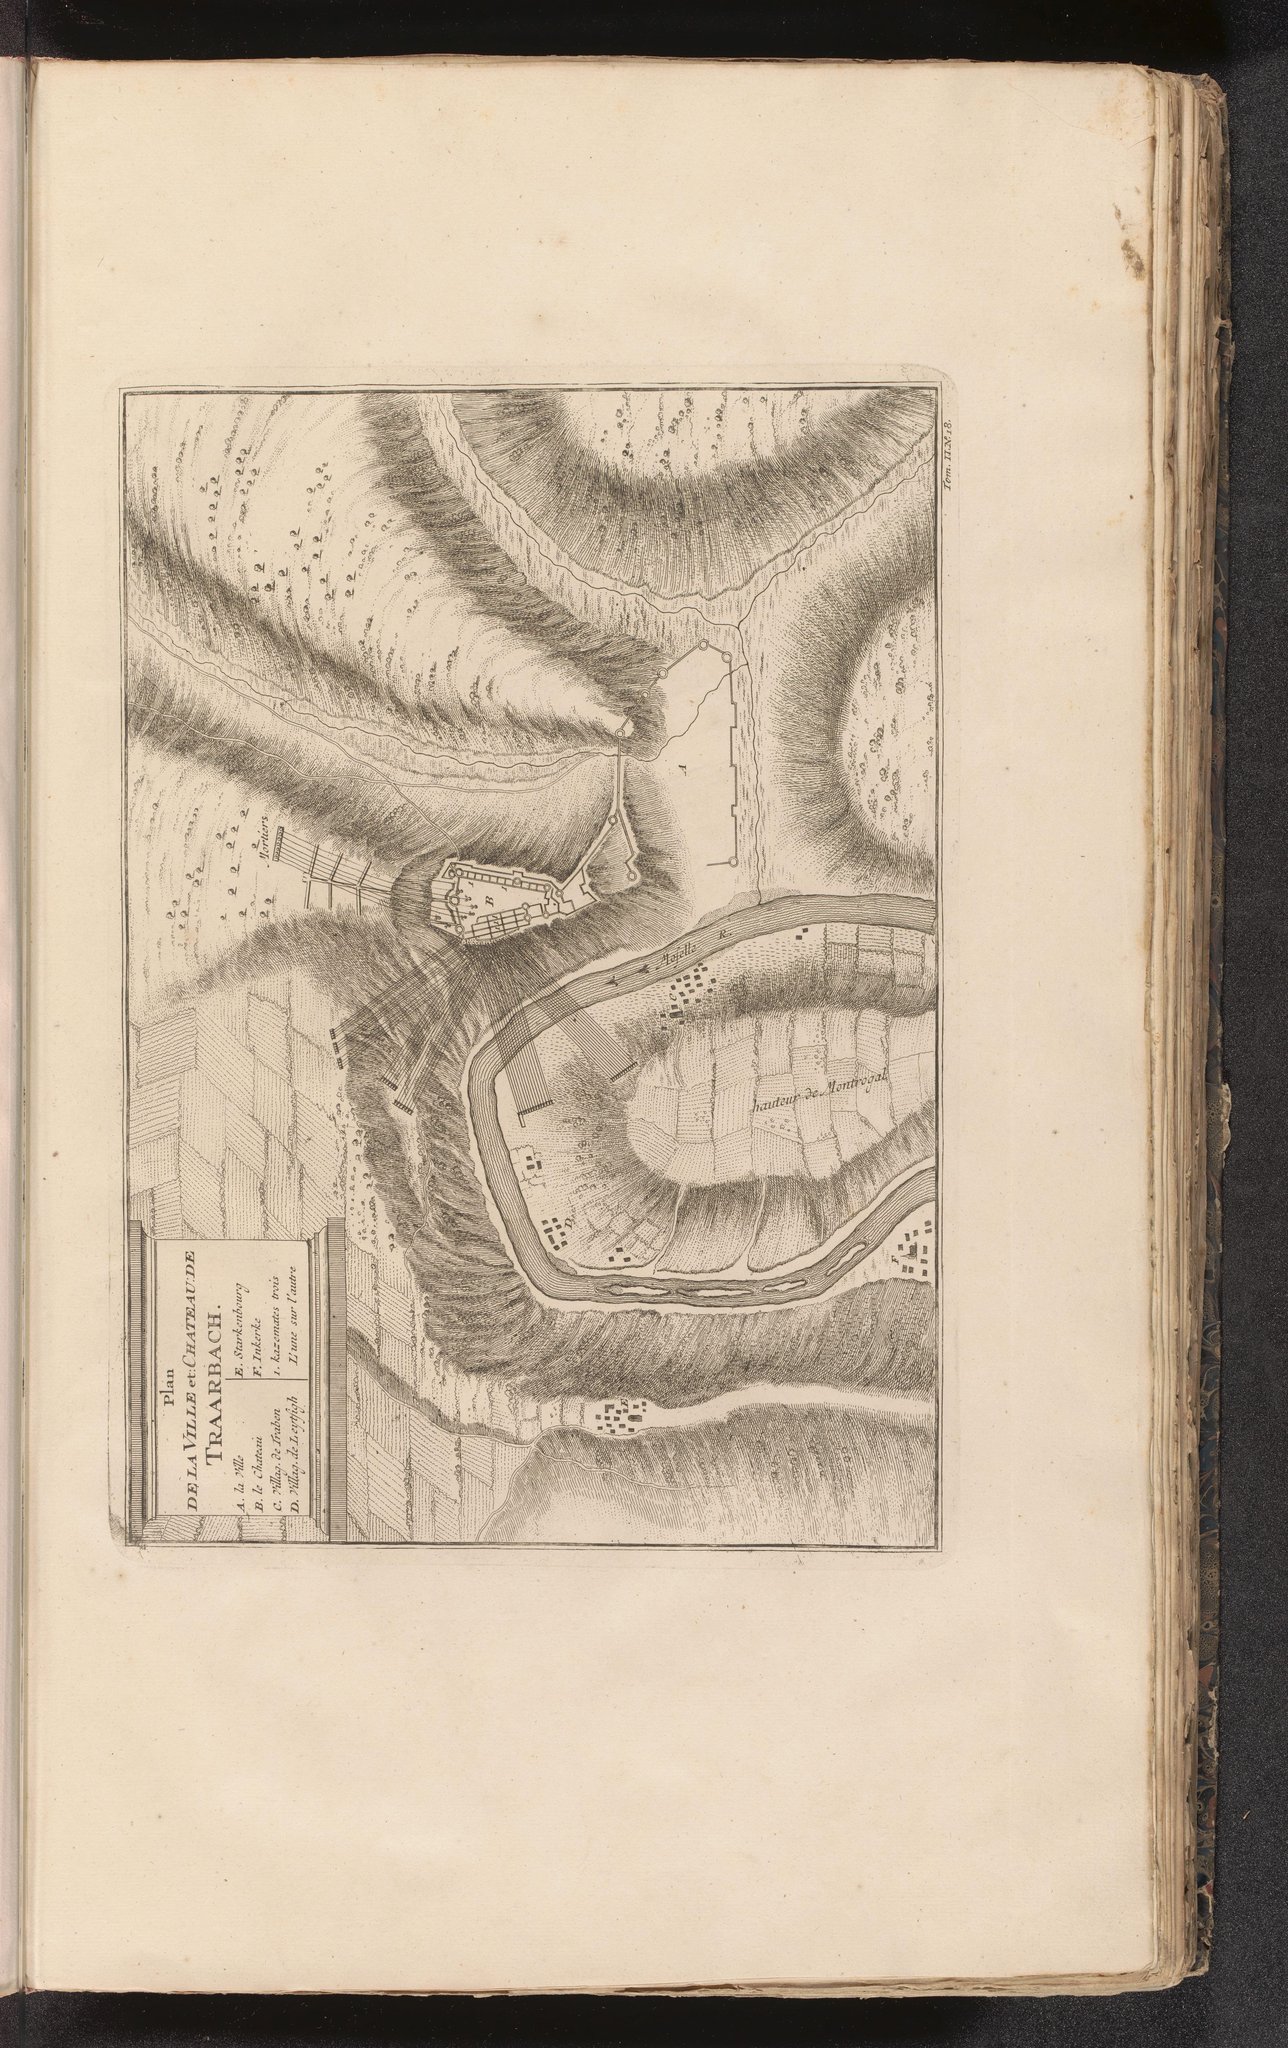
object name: print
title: Plattegrond van dorp en kasteel van Trarbach, 1704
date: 1704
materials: paper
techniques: etching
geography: northern netherlands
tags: johan willem friso (prins van oranje-nassau), john churchill (1e hertog van marlborough), siege, position war, maps of cities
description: Plattegrond van de versterkingen om de plaats Trarbach en het kasteel, belegerd door de keizerlijke troepen en ingenomen op 18 december 1704. Genummerd rechtsonder: Tom. II. No. 18. Illustratie in het tweede deel van : [Jean] du Mont, Oorlogskundige beschryving van de veldslagen en belegeringen, der drie ... wydvermaarde krygsoversten... den Prins Eugenius van Savoye, den ... Hertog van Marlborough, en den Prins van Oranje en Nassau-Vriesland, in de editie van 1729. Dit tweede deel is hoofdzakelijk gewijd aan de daden van de hertog van Marlborough en prins Johan Willem Friso.